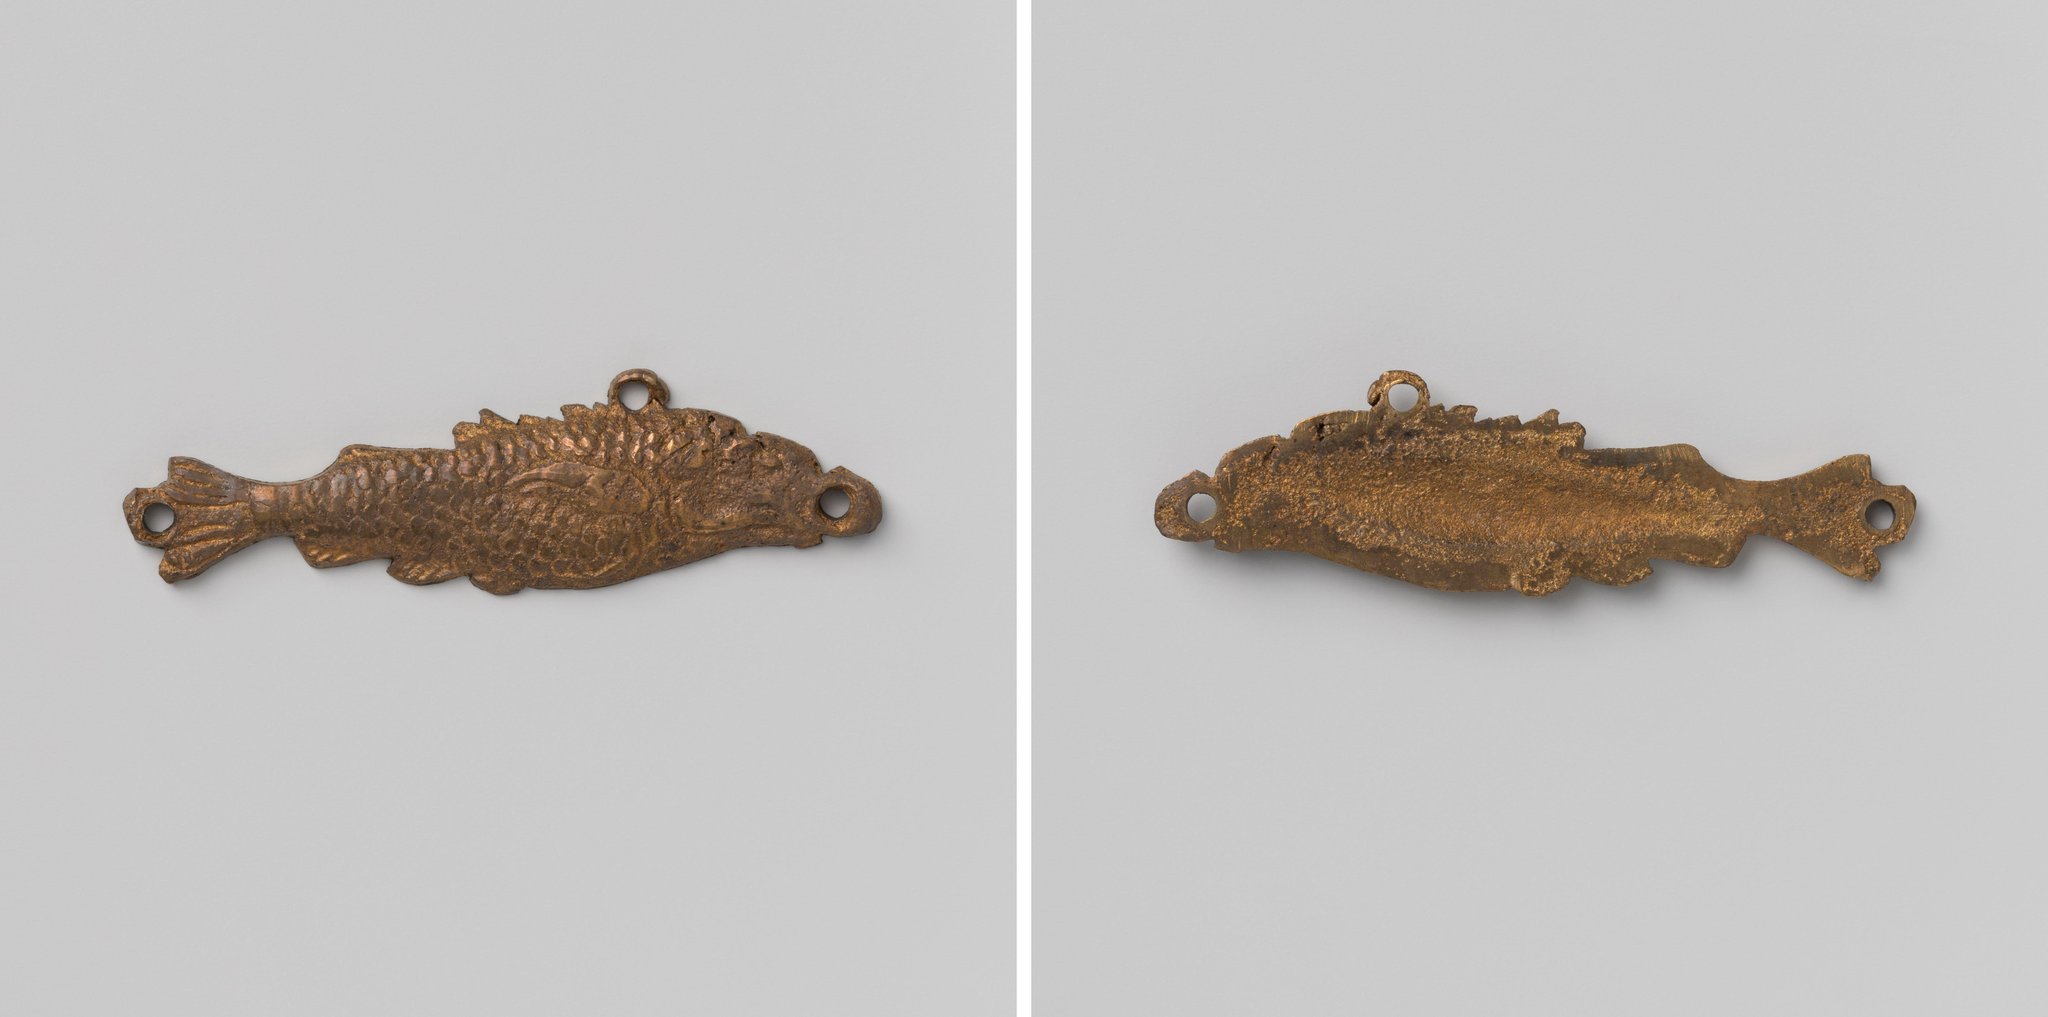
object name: insignia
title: Visdragers van Amsterdam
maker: Anonymous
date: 1800-1875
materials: brass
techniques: casting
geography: amsterdam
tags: amsterdam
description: Water and land transport. Fish porters, Amsterdam.